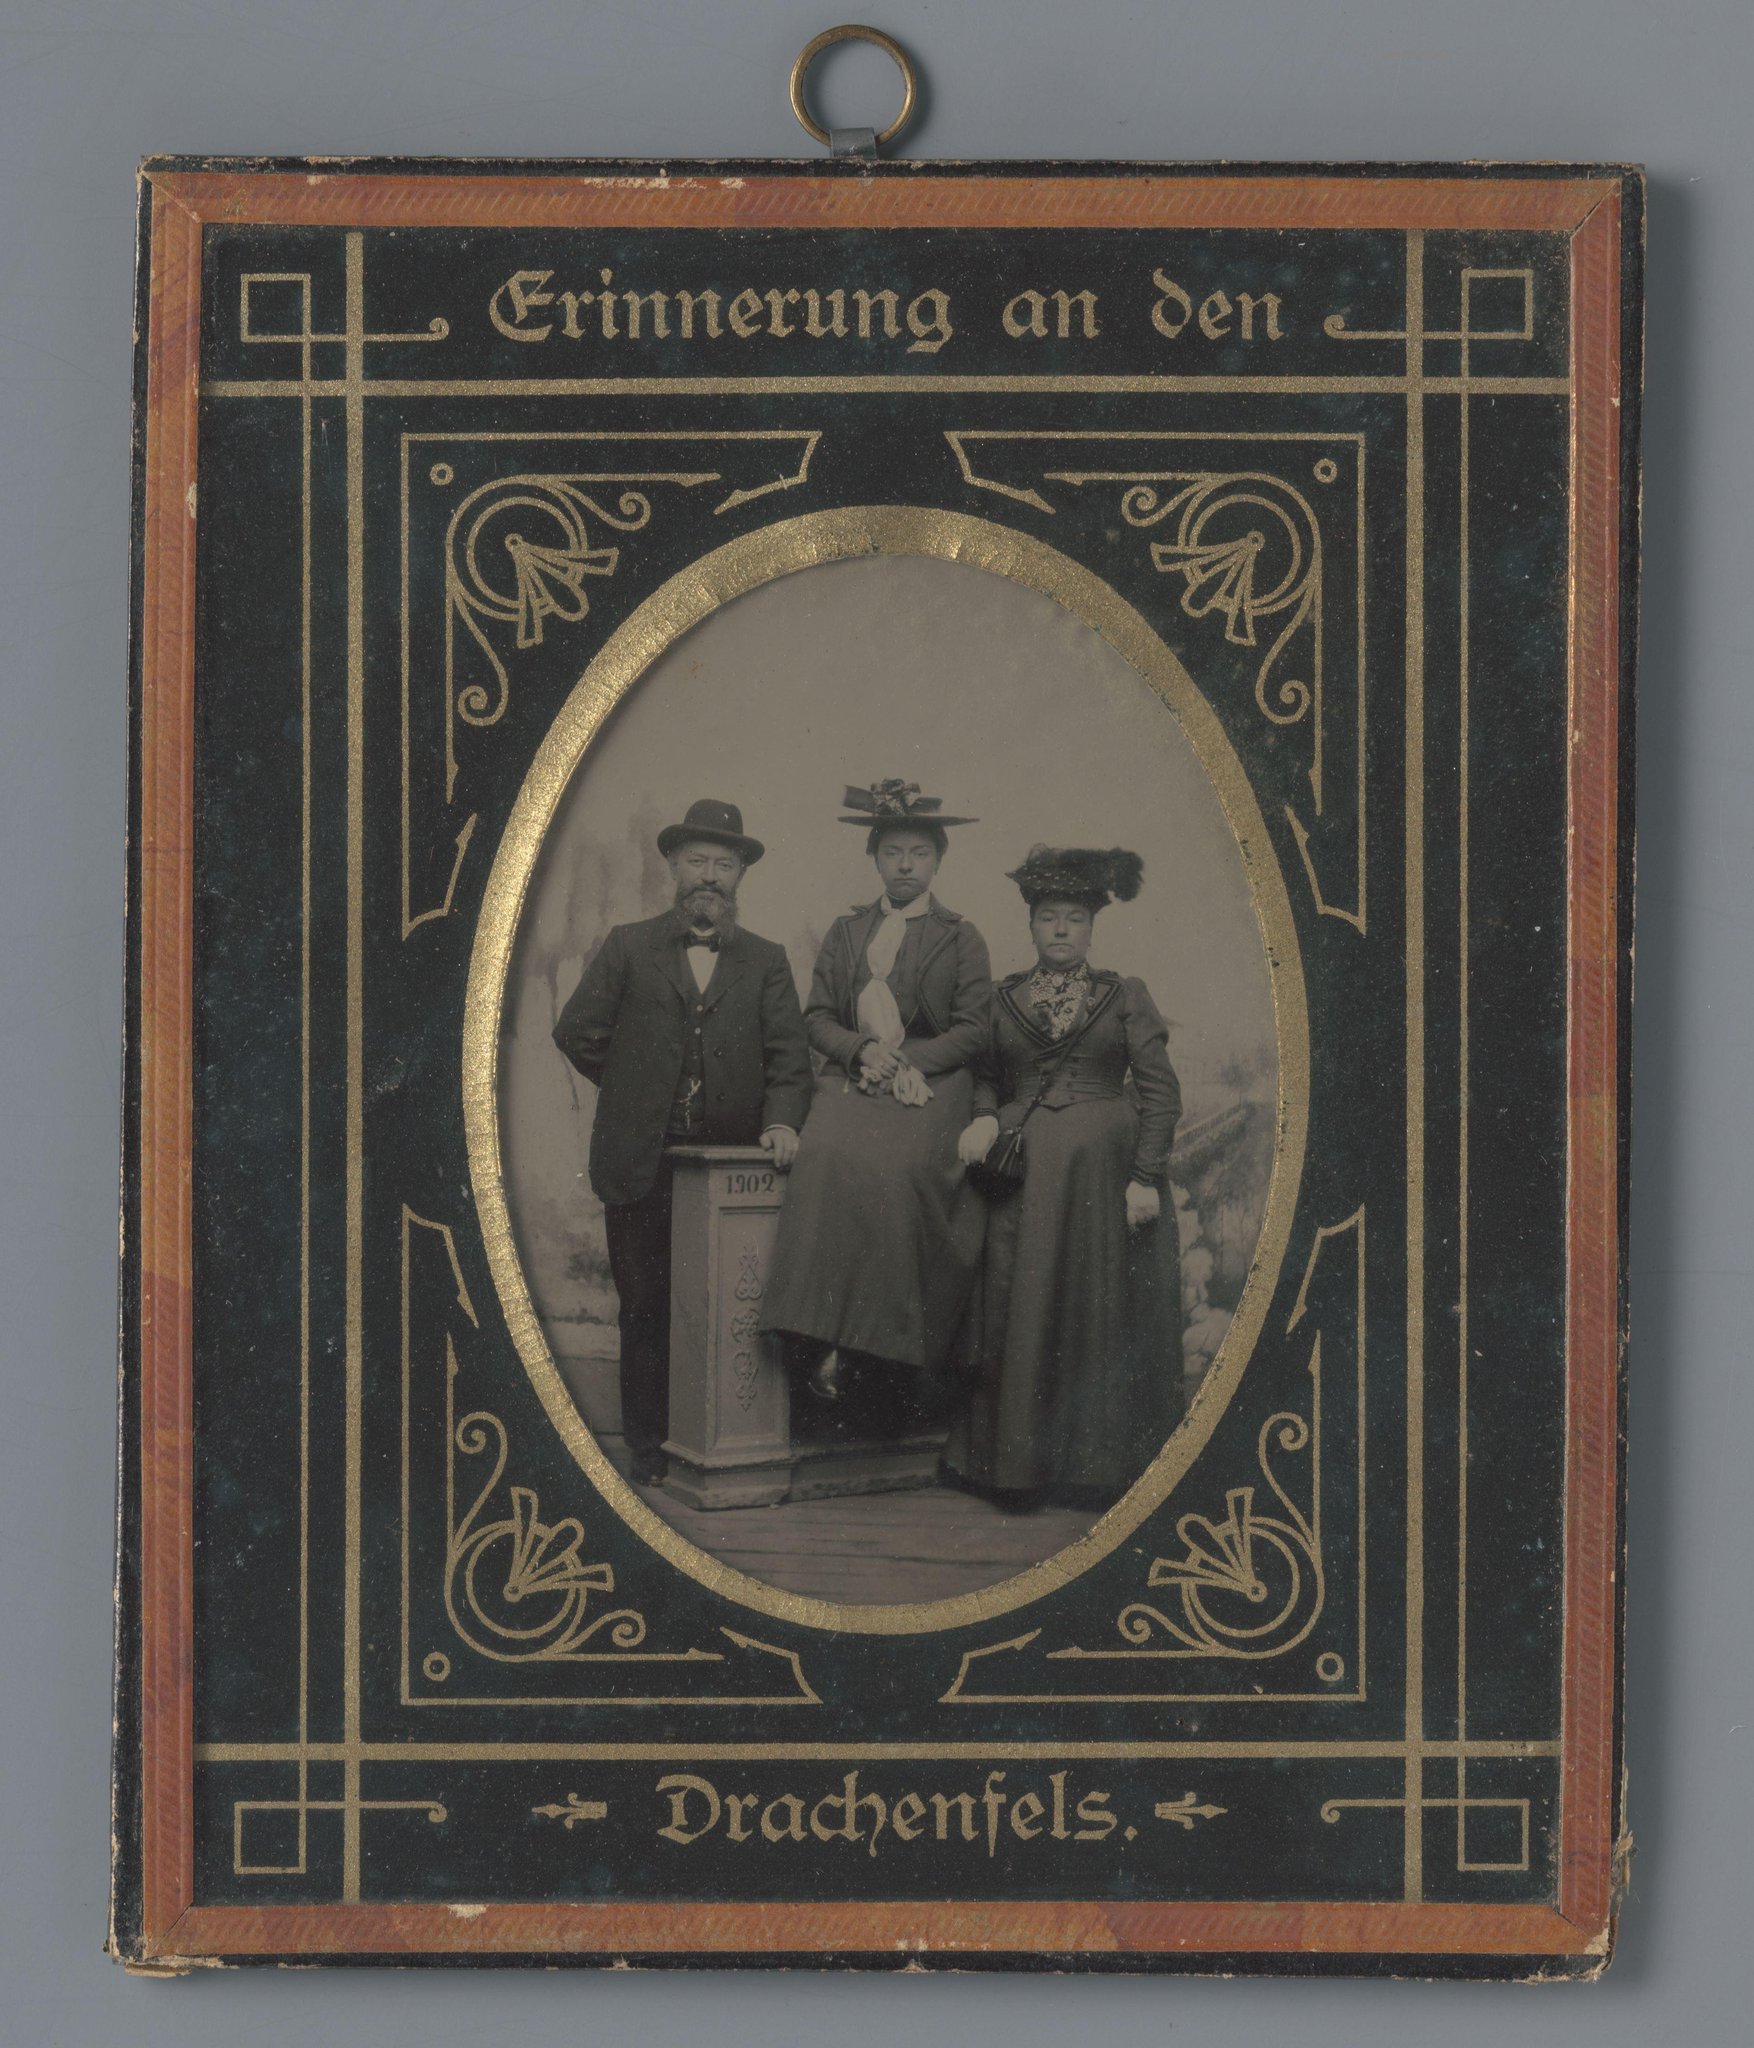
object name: frame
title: Portret van een man en twee vrouwen met hoeden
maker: Anonymous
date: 1855-1900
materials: glass, iron, metal, paper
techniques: ferrotyping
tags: historical persons - bb - woman, historical persons, head-gear: hat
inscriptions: inscription: ‘Erinnerung an den Drachenfels’